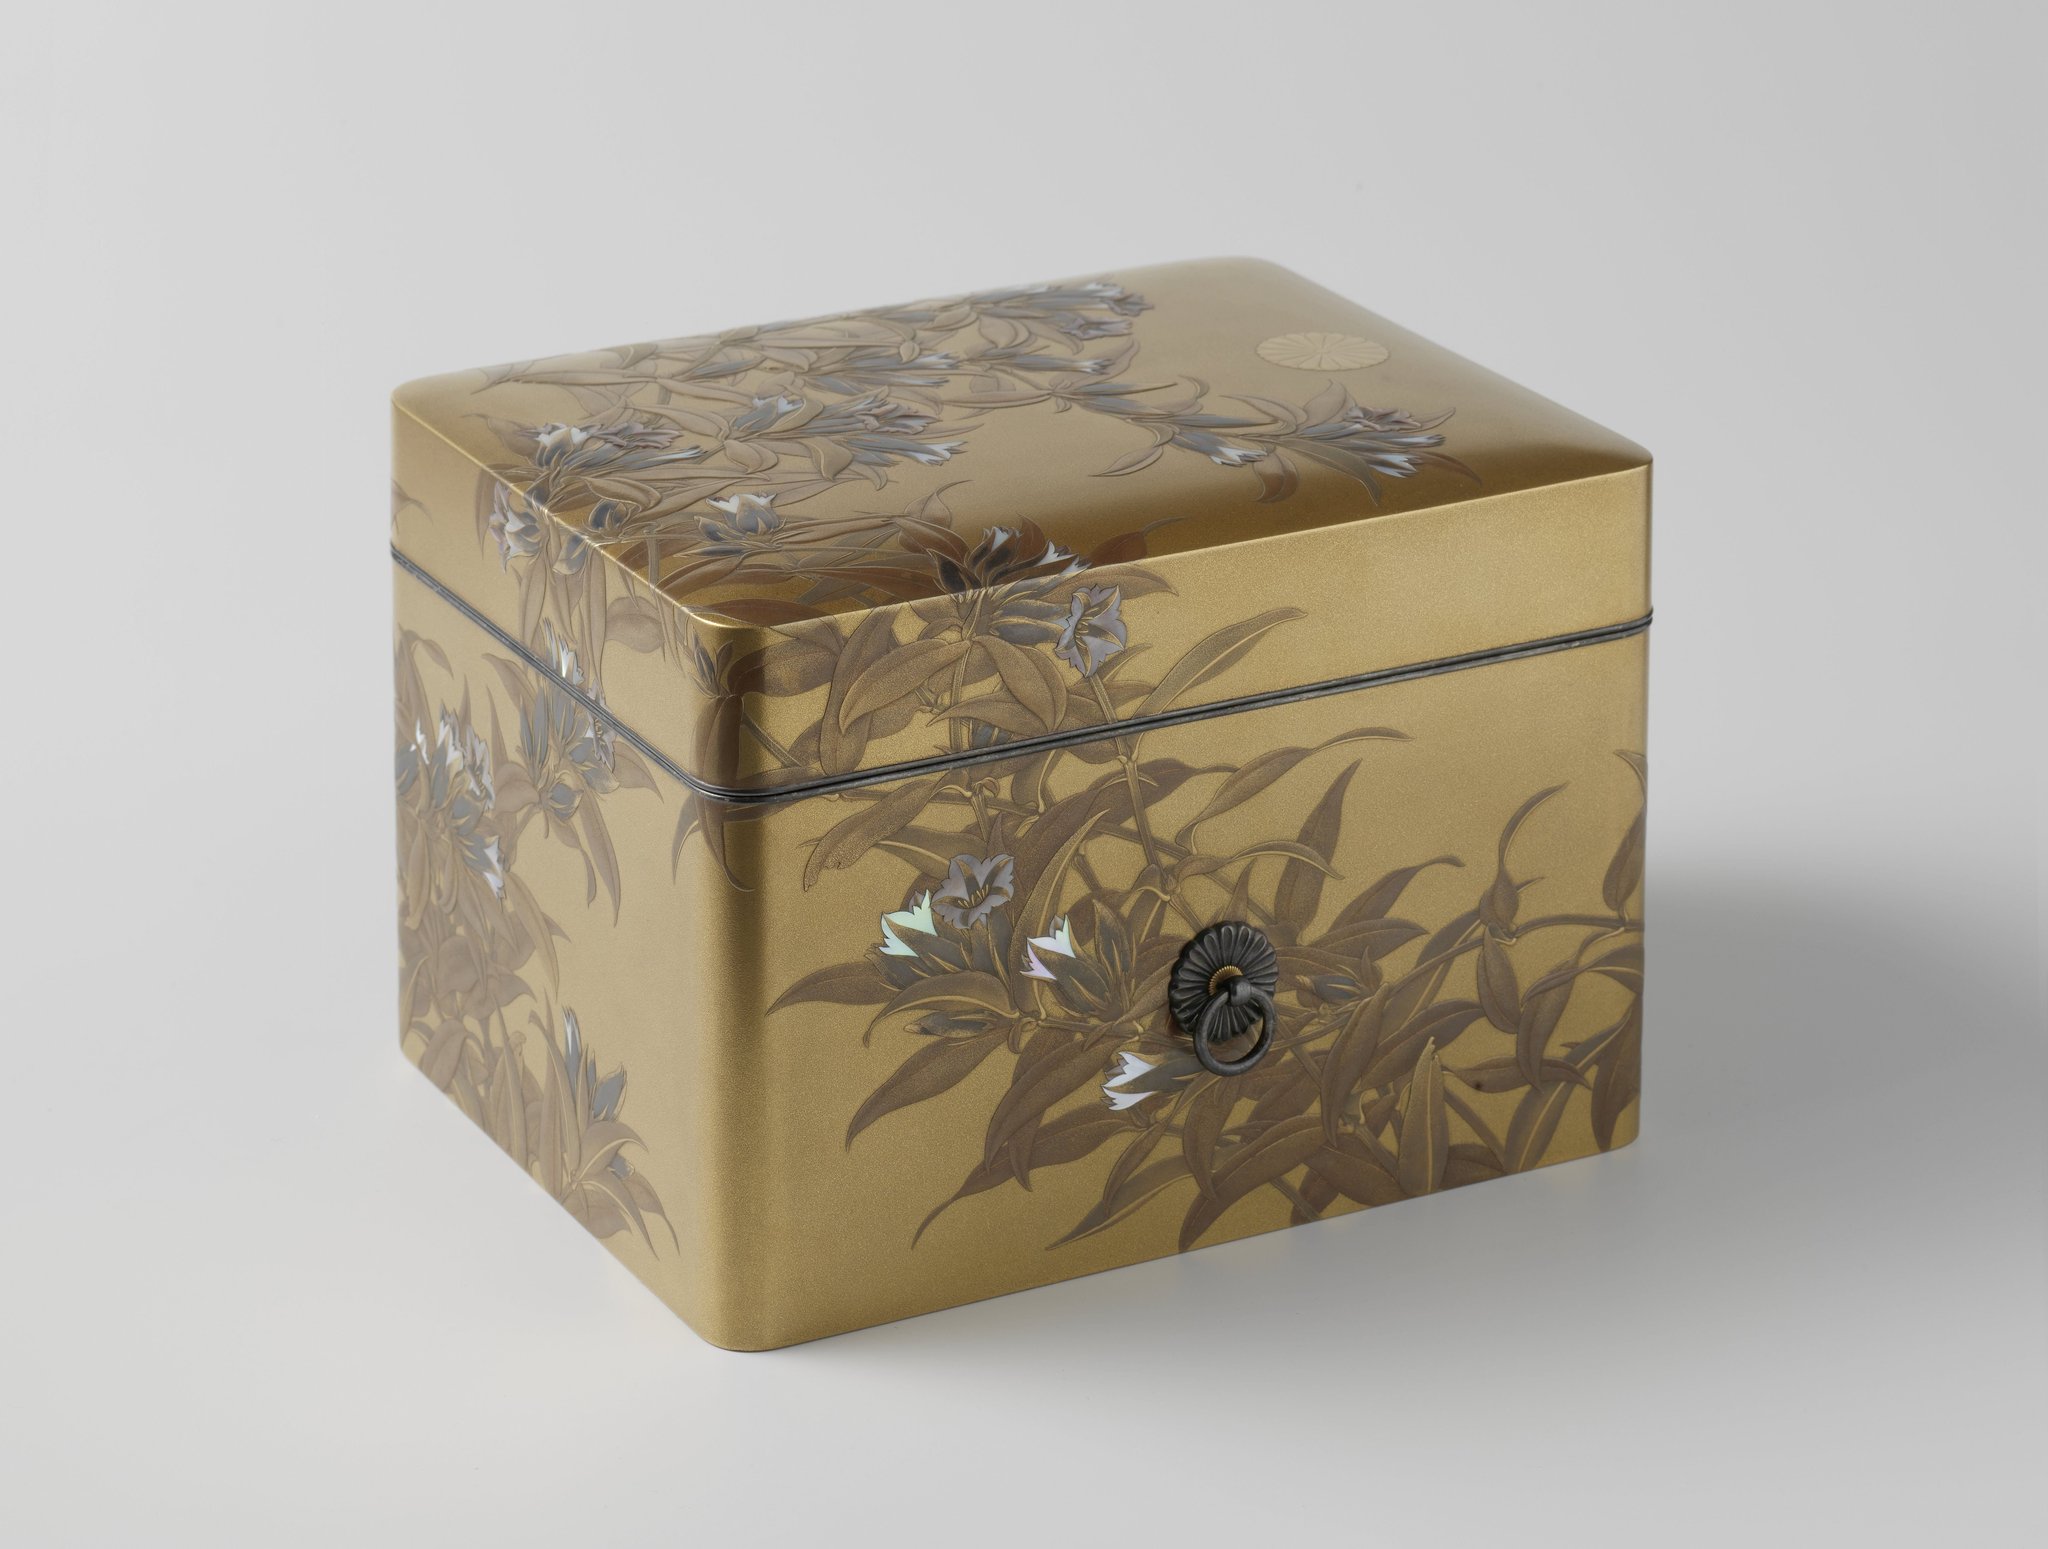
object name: box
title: Accessory Box ‘Gentian’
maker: akatsuka jitoku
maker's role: lacquerer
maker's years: 1871-1936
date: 1910-1925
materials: gold, lacquer, mother of pearl, silver, wood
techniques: nashiji, maki-e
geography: japan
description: The Imperial Chrysanthemum crest indicates that this box was a gift from the Emperor. Again, Jitoku has used the rich, grainy gold ground to give the box a special aura. The gentian flowers, in sprinkled silver powder and motherof- pearl inlay, seem to light up in the summer sun.